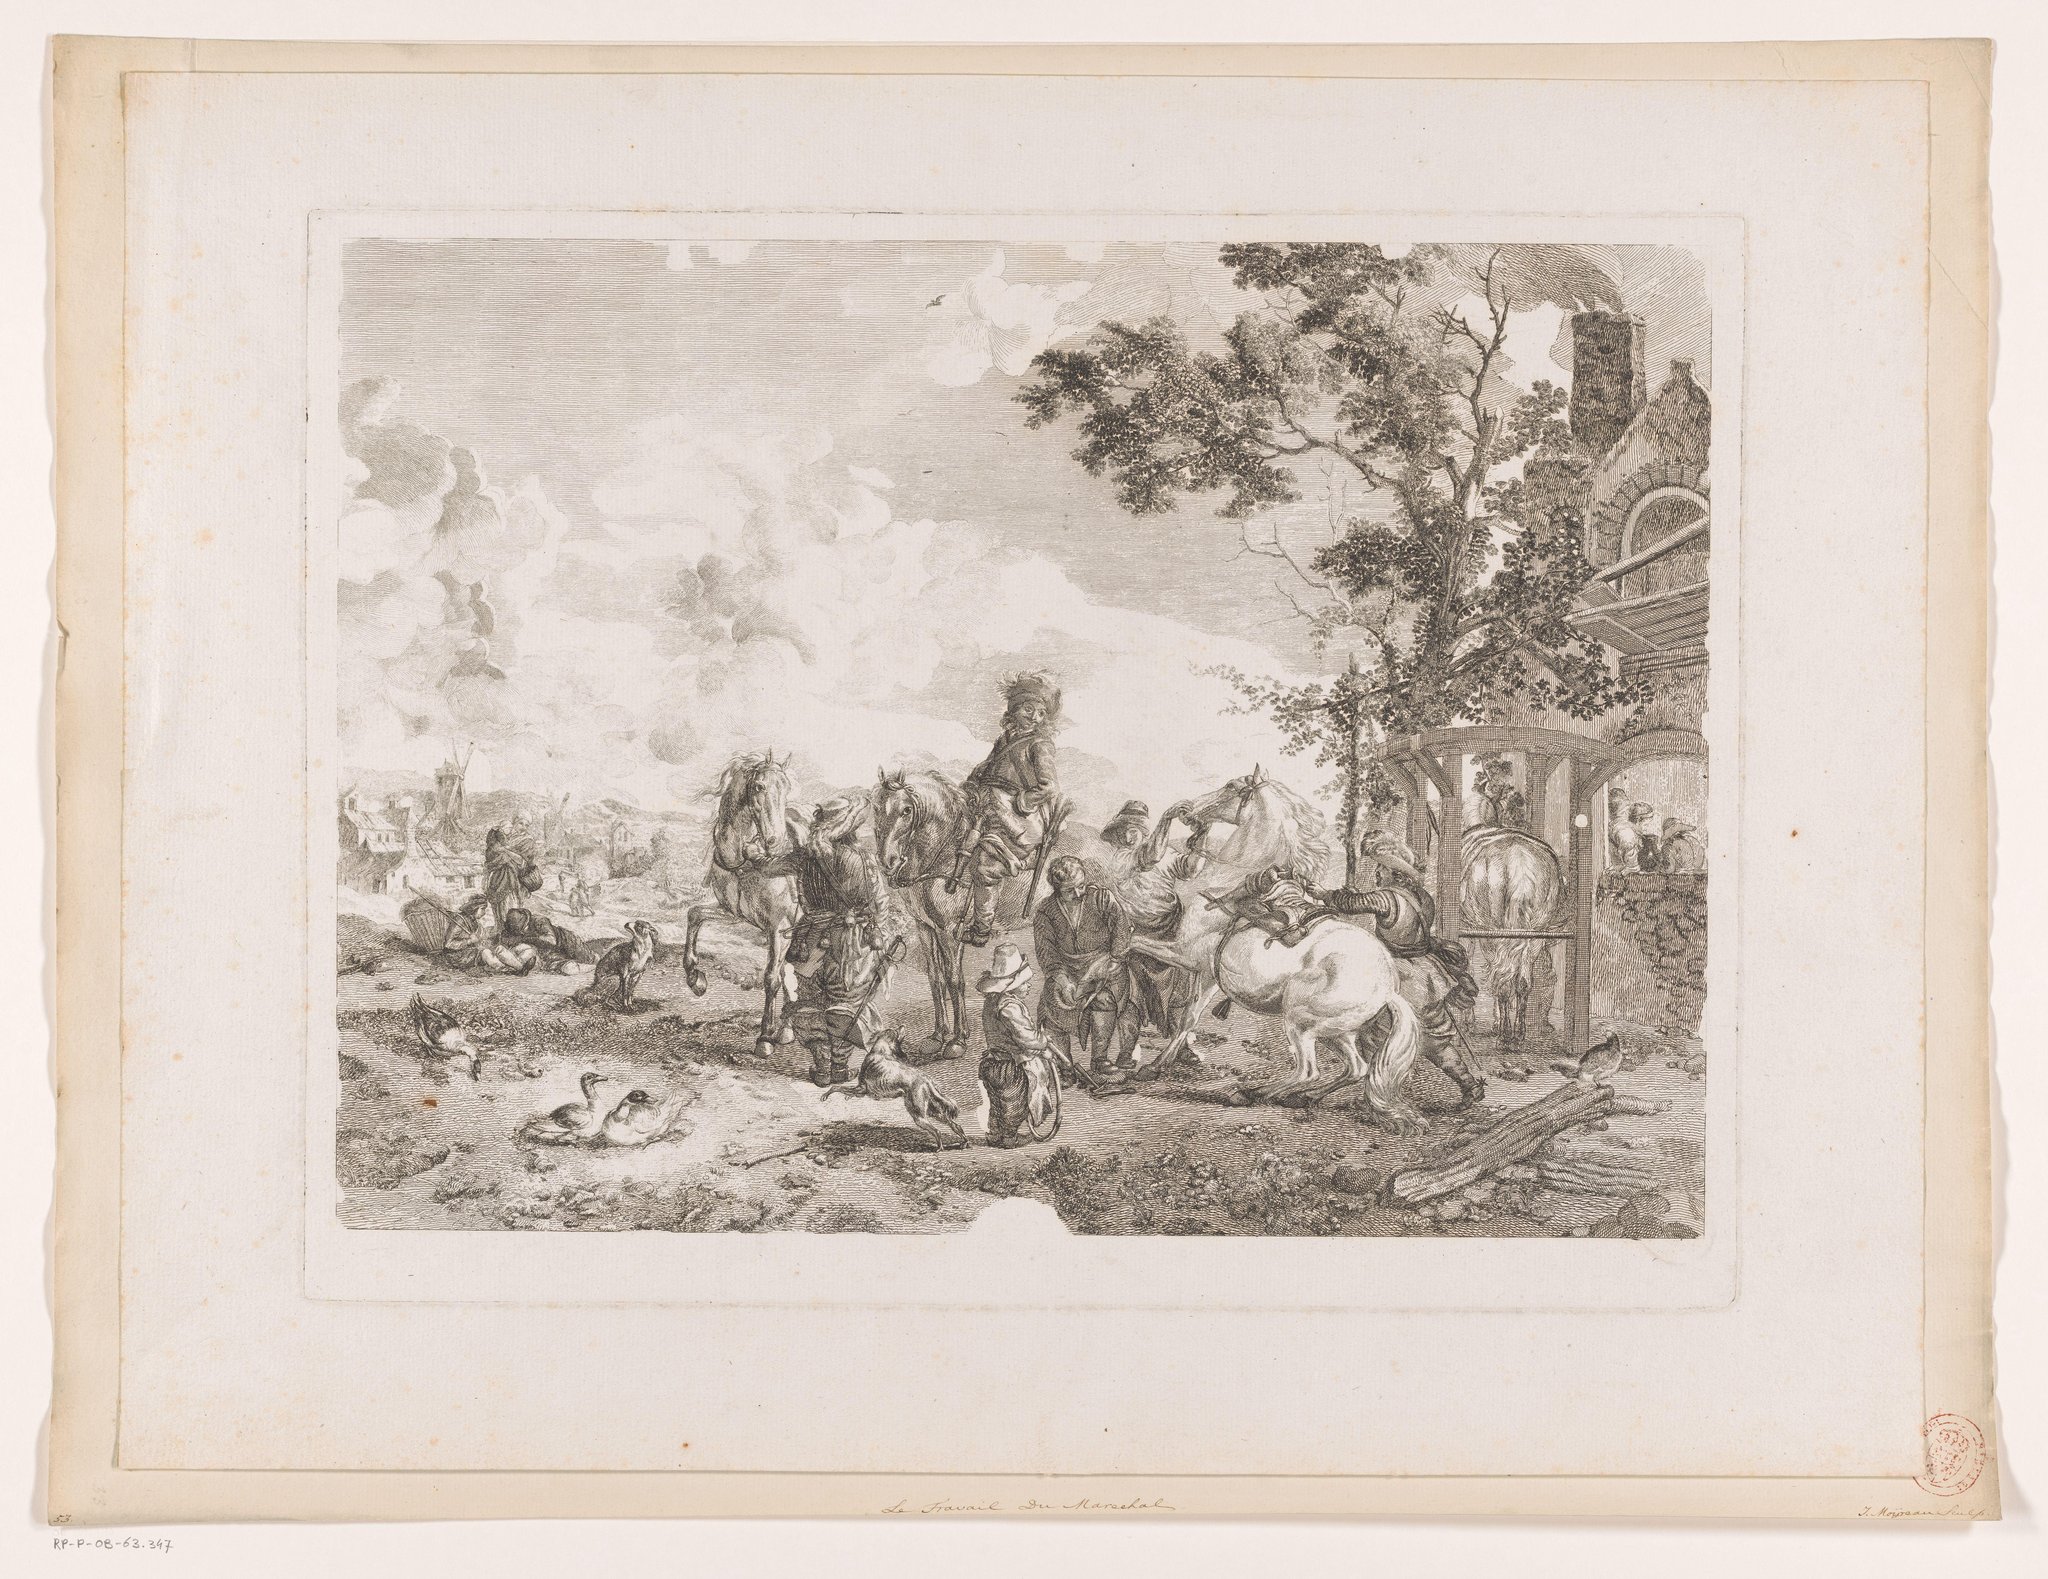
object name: print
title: Le Travail du Marechal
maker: jean moyreau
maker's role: print maker, publisher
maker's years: 1690-1762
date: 1746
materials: paper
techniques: etching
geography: france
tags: riding a horse, ass, or mule; rider, horseman, farrier, shoeing-smith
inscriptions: inscription: ‘f 21-10-’, collector's mark: Lugt 240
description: Maakt deel uit van een serie van 89 prenten te dateren tussen ca. 1733-1762, naar het geschilderde oeuvre van Philips Wouwerman. Dit betreft plaat 53.